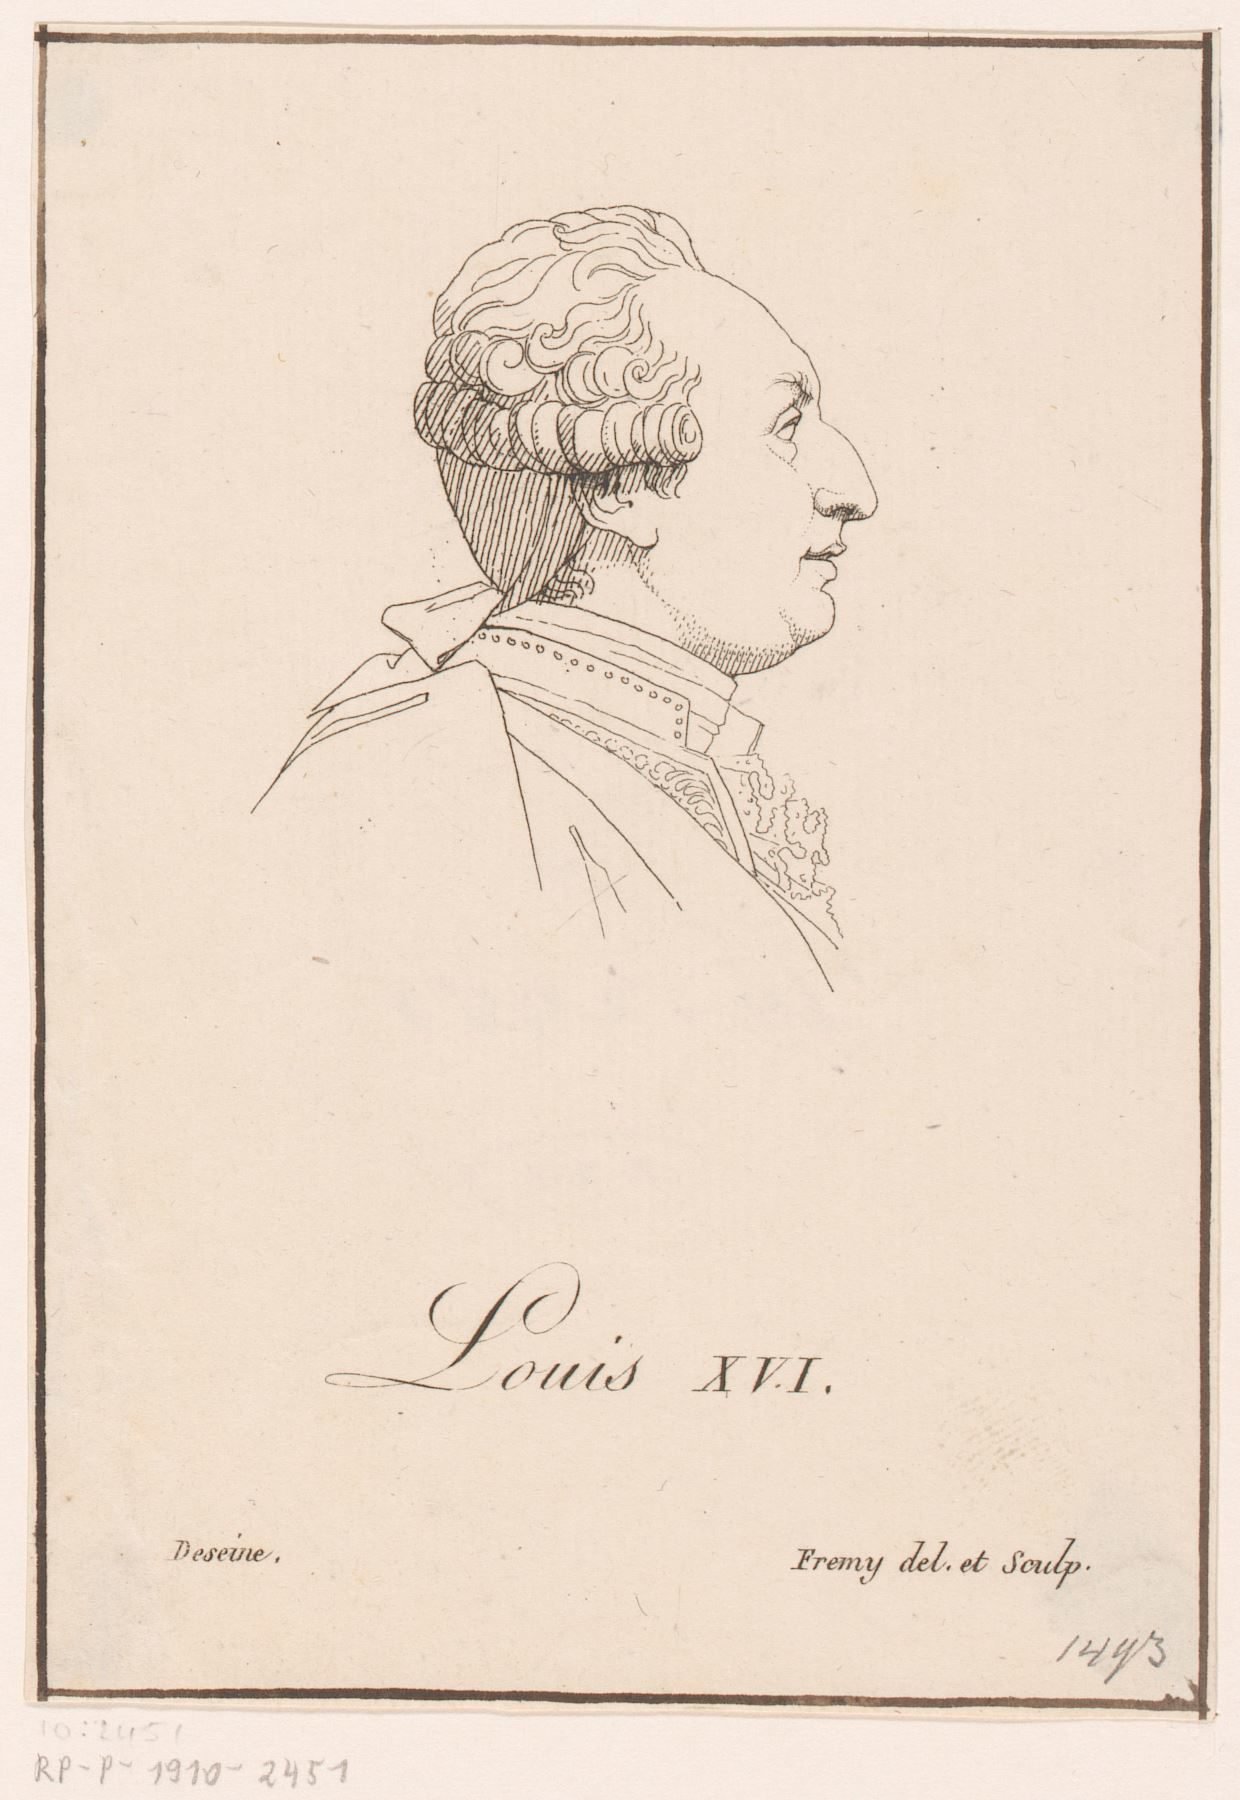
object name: book illustration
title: Louis XVI.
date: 1815-1817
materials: paper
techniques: etching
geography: france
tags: paris, lodewijk xvi (koning van frankrijk), historical persons, ruler, sovereign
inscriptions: collector's mark: Lugt 2228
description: Prent uit: Frémy, Jacques Noël Marie. Croquis de portraits des personnages remarquables dans tous les genres, dessinés et gravés. Parijs: Jacques Noël Marie Frémy, 1815-1817.